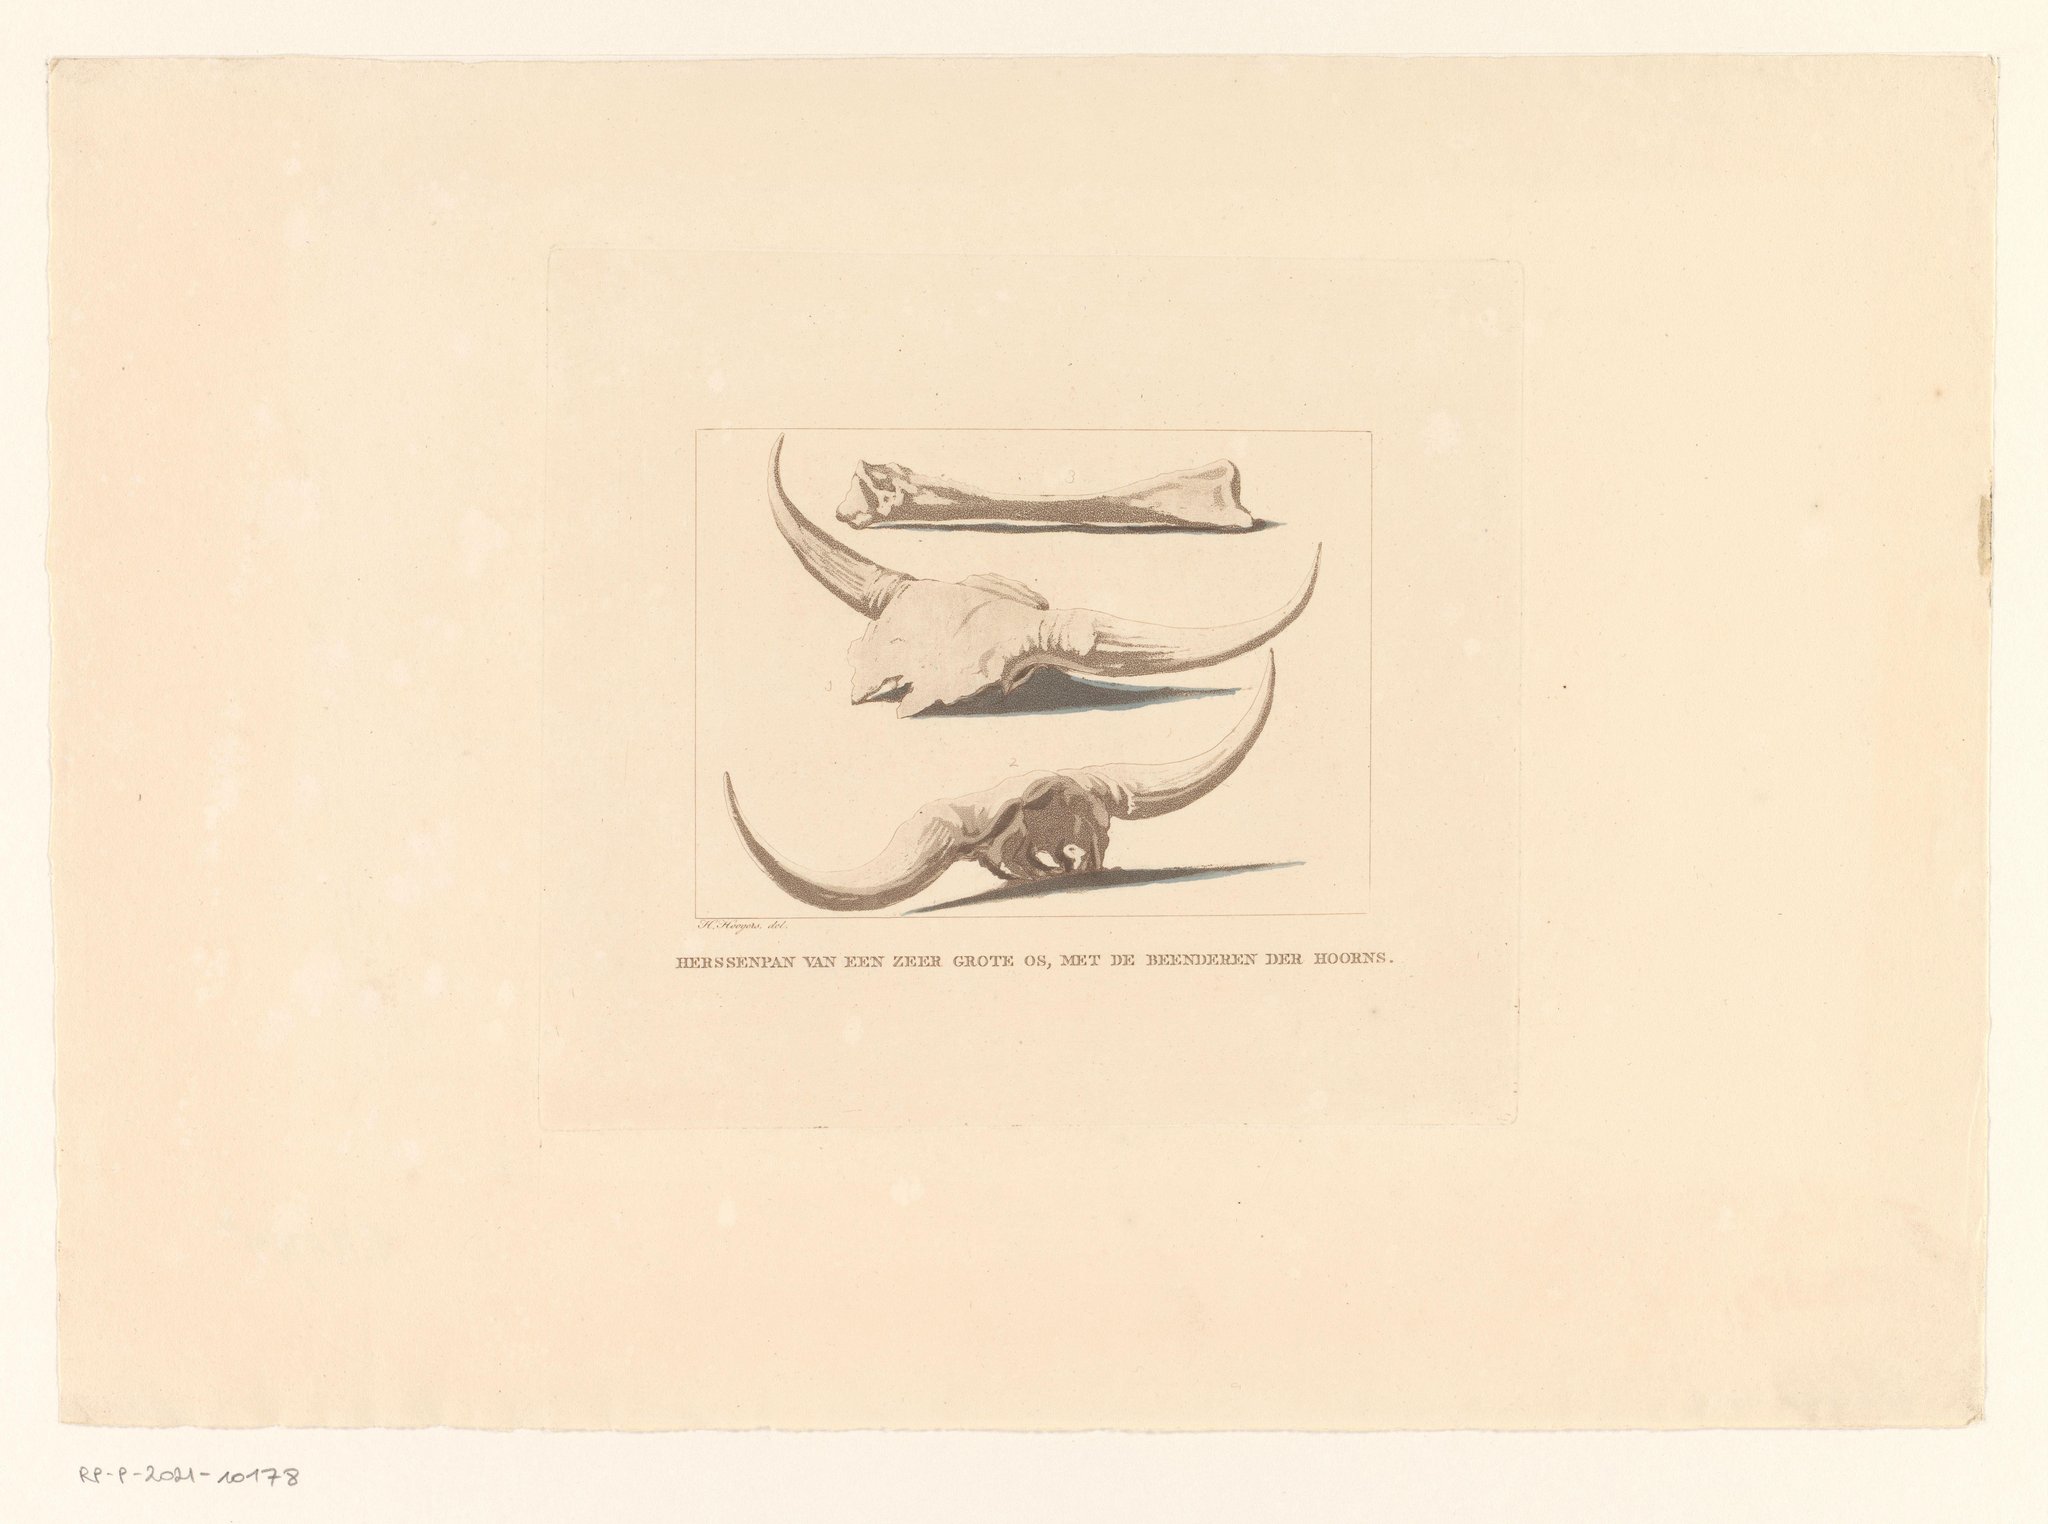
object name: book illustration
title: Fossiele beenderen van een oeros, gevonden tijdens de watersnood, 1809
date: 1809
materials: paper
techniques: aquatint, etching, hand coloring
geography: netherlands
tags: fossil animals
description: Prent waarschijnlijk uit een deel van: Ewijk, Hendrik. Geschiedkundig verslag der dijkbreuken en overstroomingen, langs de rivieren in het Koningrijk Holland, voorgevallen in louwmaand MDCCCIX. 3 dln. Amsterdam: Johannes Allart en Jacobus Ruys, 1809.